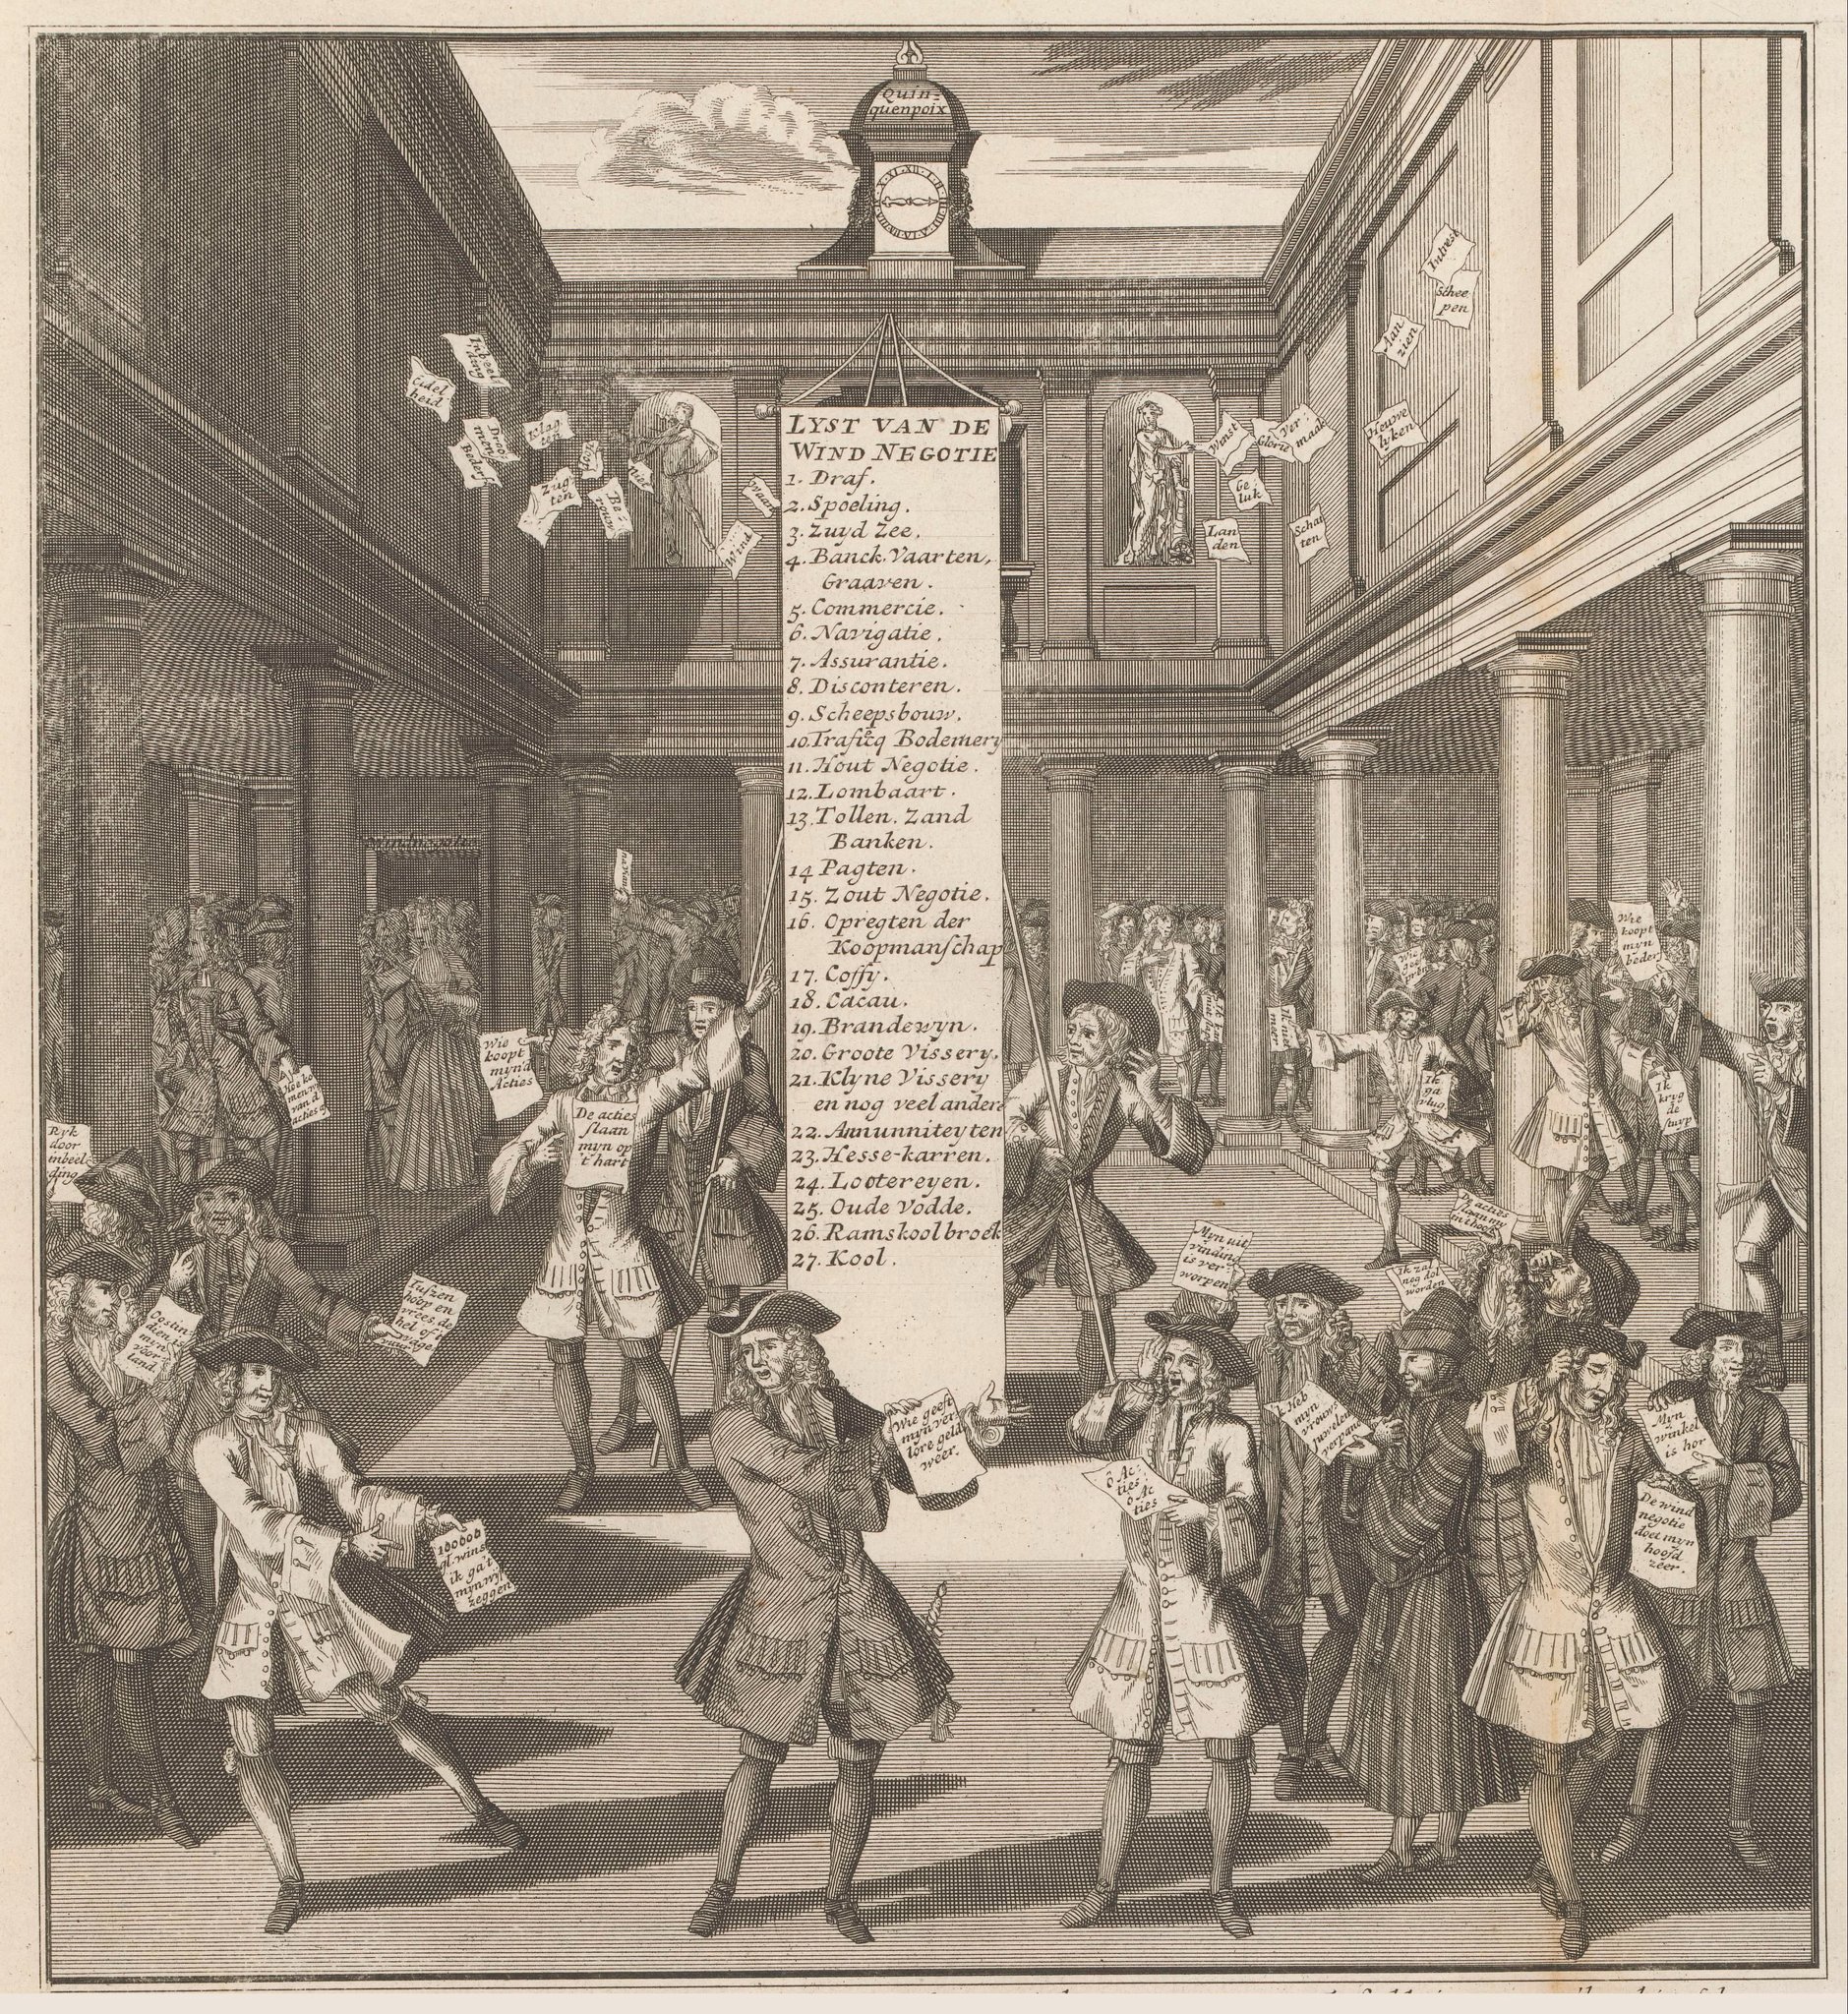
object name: print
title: Het Groote Tafereel der Dwaasheid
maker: Anonymous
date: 1720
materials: paper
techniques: etching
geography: northern netherlands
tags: financial panic, stock exchange, stock-market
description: Wanhopige handelaren, slachtoffers van de windhandel, op de binnenplaats van de beurs van Amsterdam, 1720. In het midden hangt een lijst met de producten van de windnegotie. In het onderschrift een vers in drie kolommen door Bombario. Prent in de gebonden eerste uitgave (304 B 10) van Het Groote Tafereel der Dwaasheid met spotprenten op de Windhandel of Actiehandel van 1720.